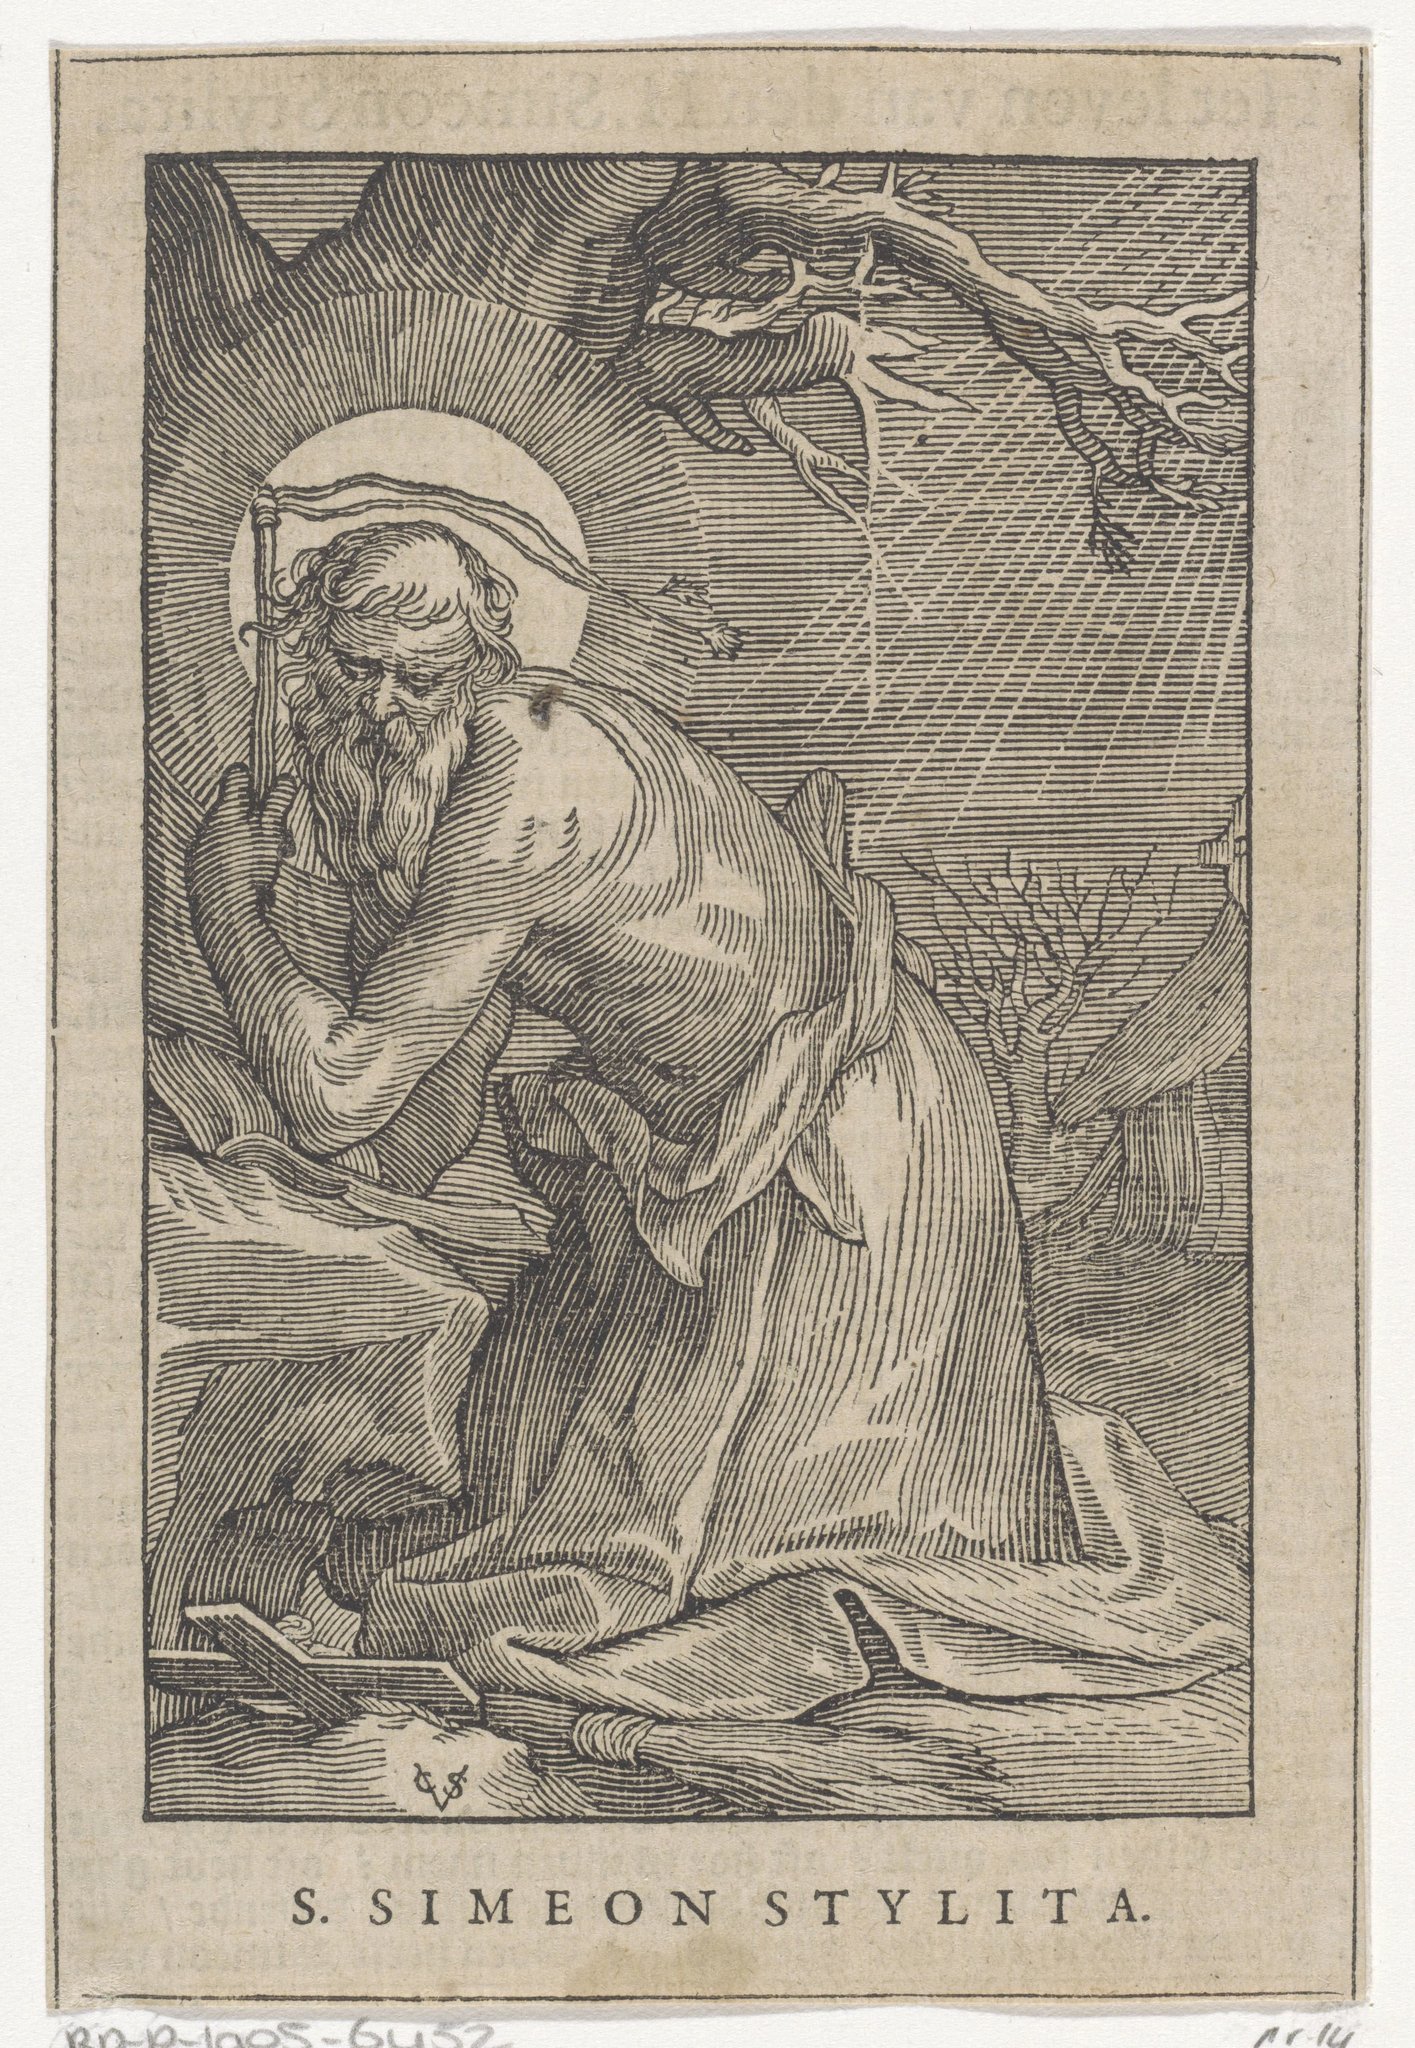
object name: print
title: Heilige Simeon Stylites de Oudere als kluizenaar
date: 1644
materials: paper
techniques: letterpress printing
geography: amsterdam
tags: anchorite, hermit, the hermit simeon stylites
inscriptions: collector's mark: Lugt 2228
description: Prent uit: Rosweyde, Heribert. 'tBosch der eremyten ende eremitinnen, van Aegypten ende Palestinen. Amsterdam: Pieter Jacobsz. Paets, 1644.